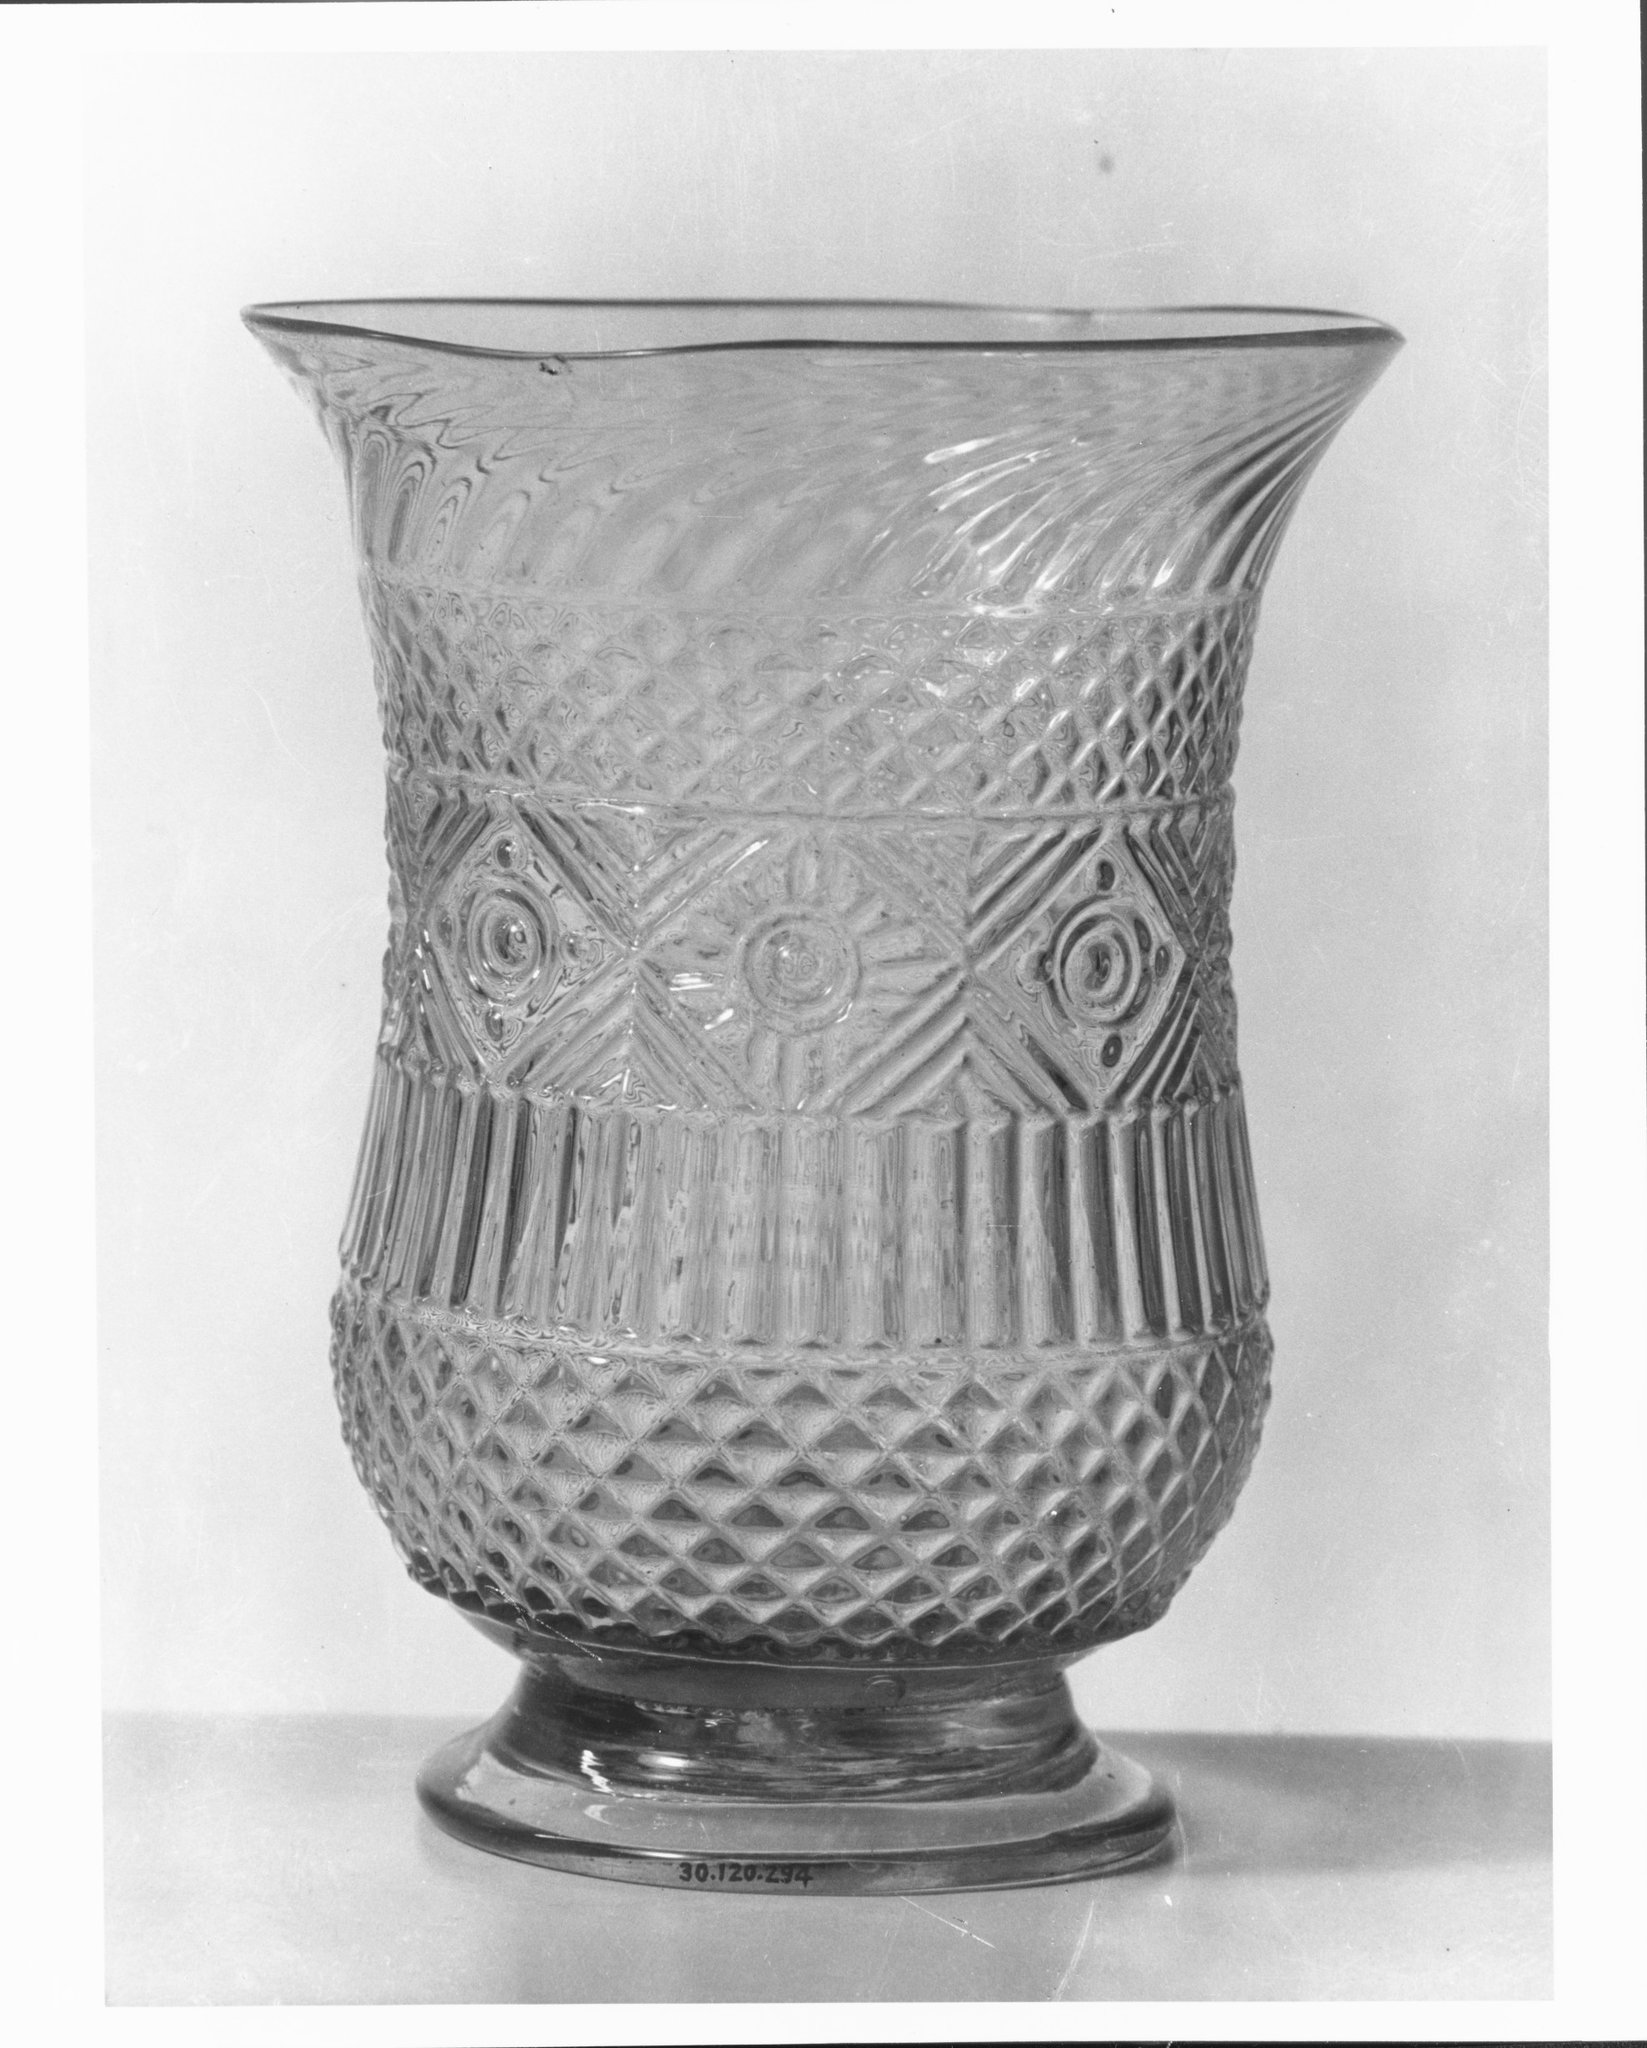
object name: celery glass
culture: american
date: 1820-1840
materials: glass, lead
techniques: glassblowing, molding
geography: united states